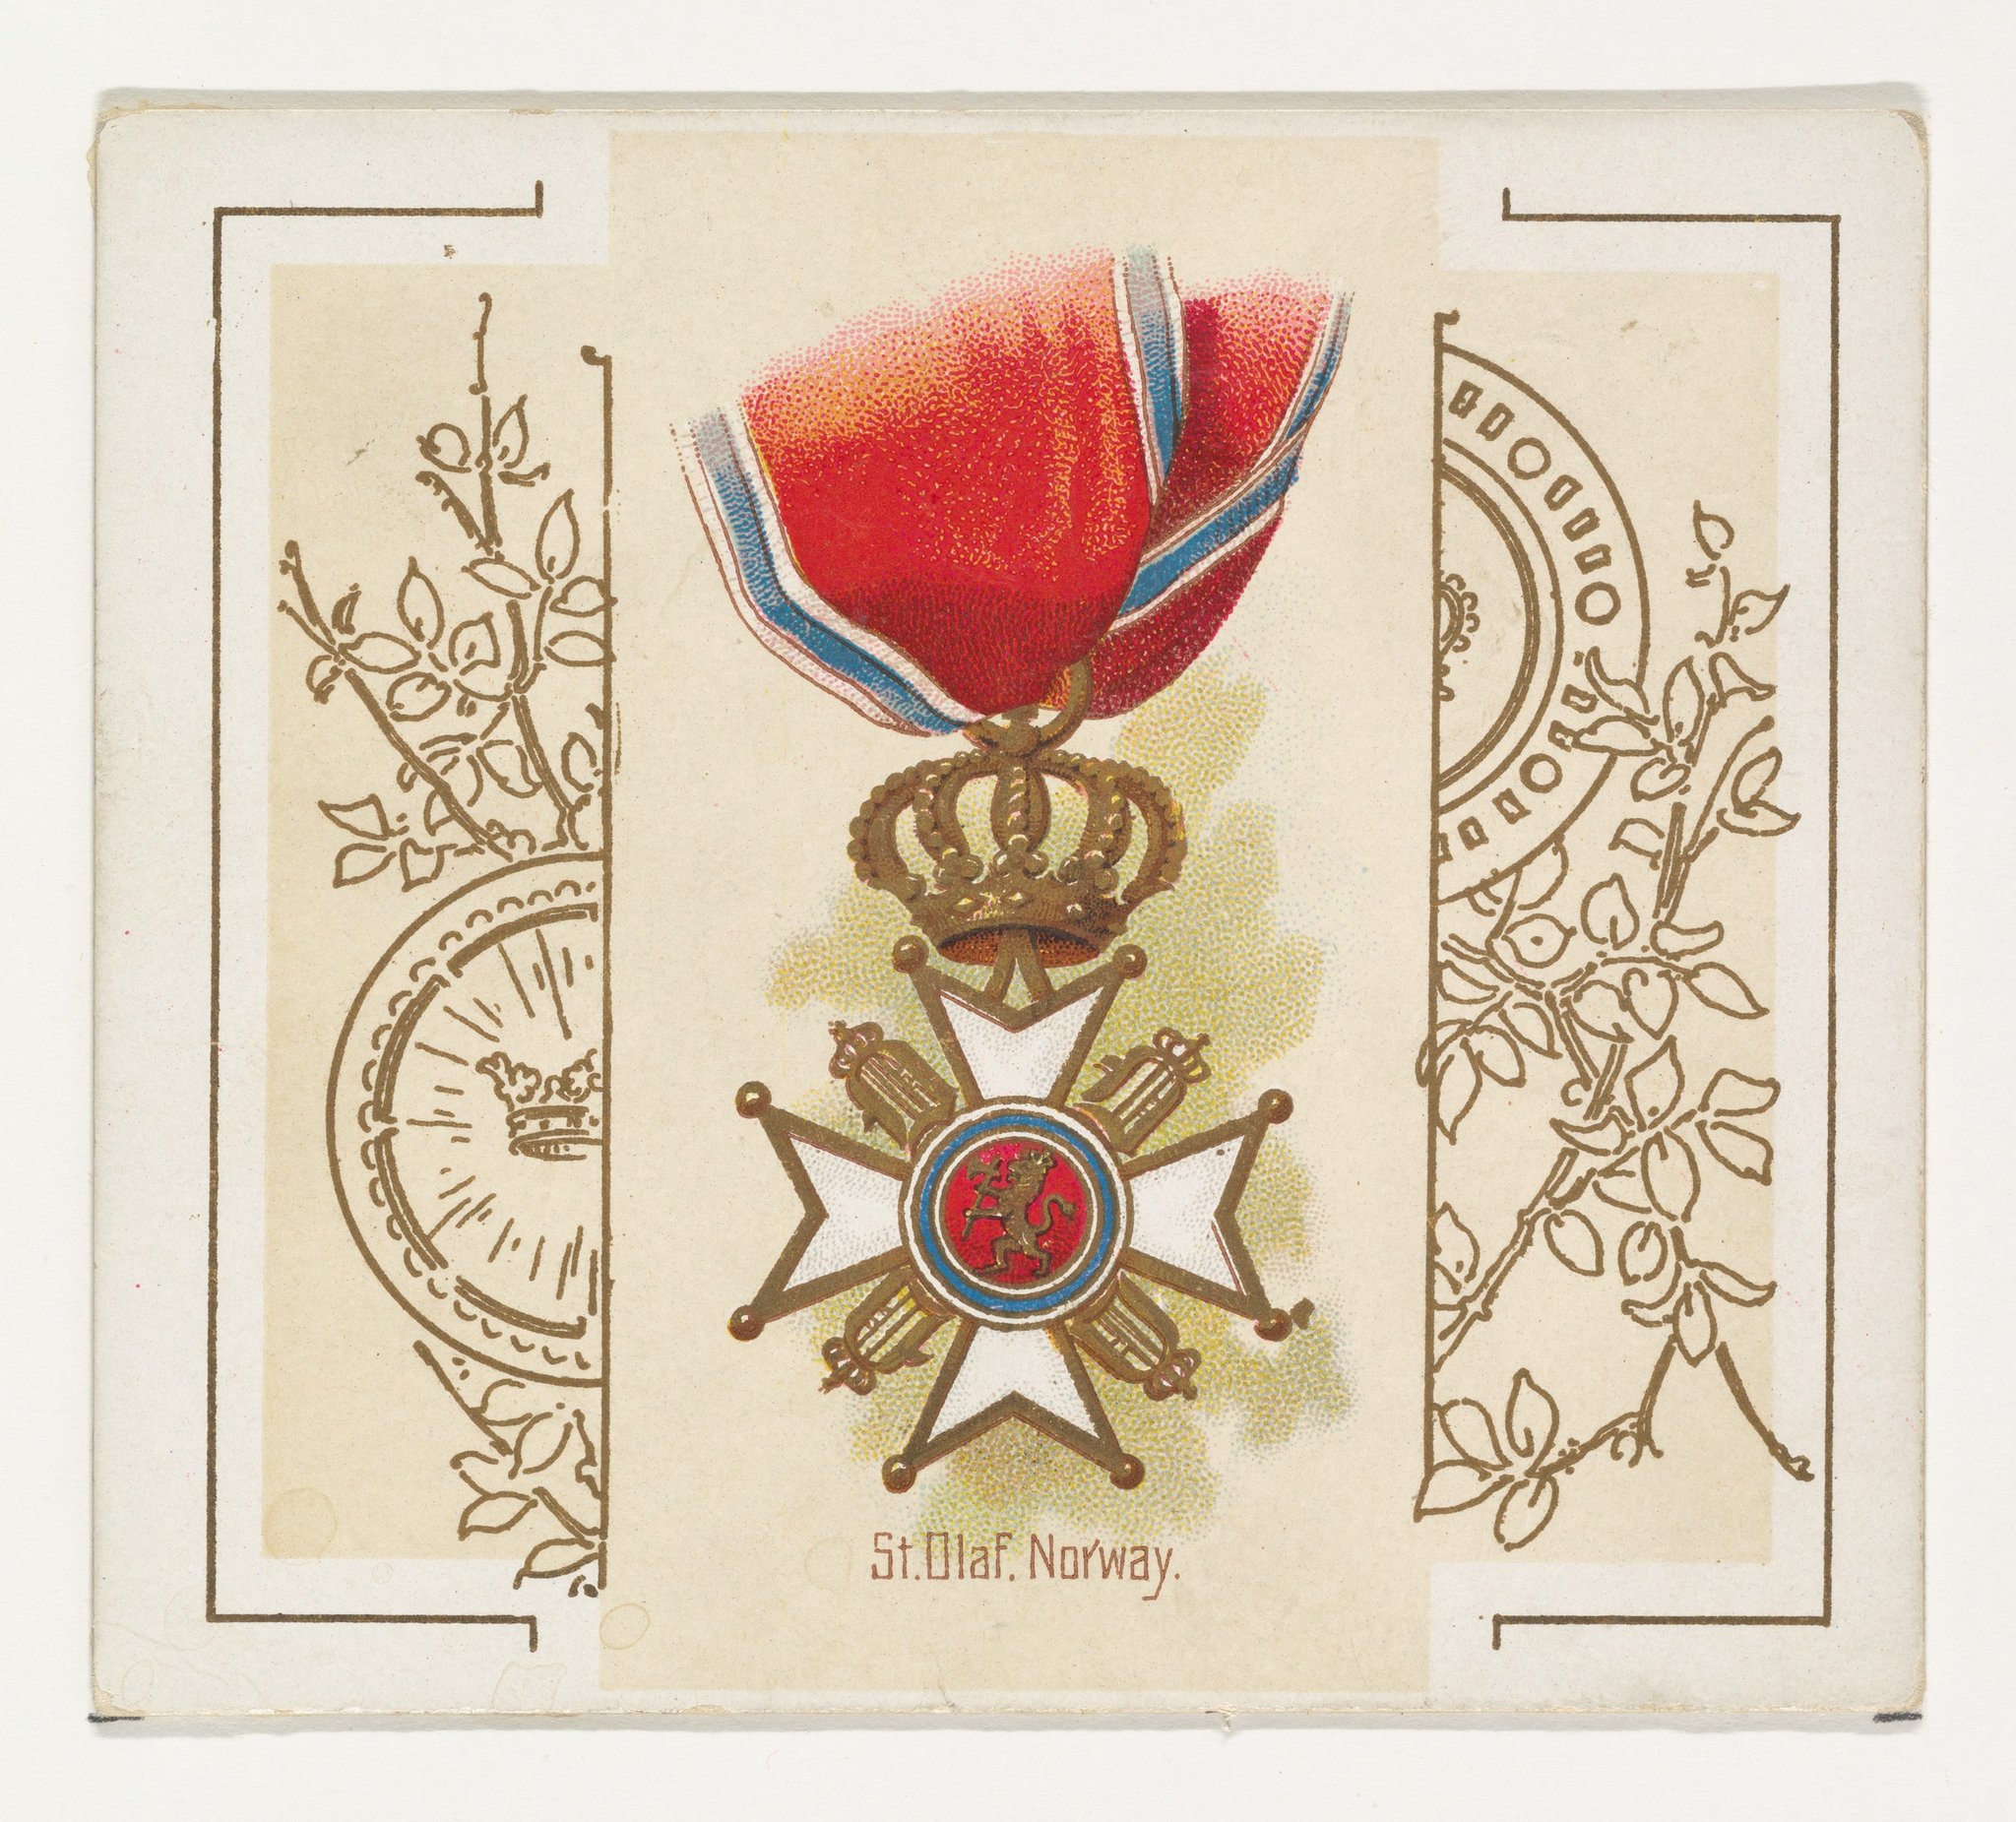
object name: print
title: Saint Olaf, Norway, from the World's Decorations series (N44) for Allen & Ginter Cigarettes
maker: allen & ginter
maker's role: publisher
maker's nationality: american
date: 1890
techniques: color lithograph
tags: medals